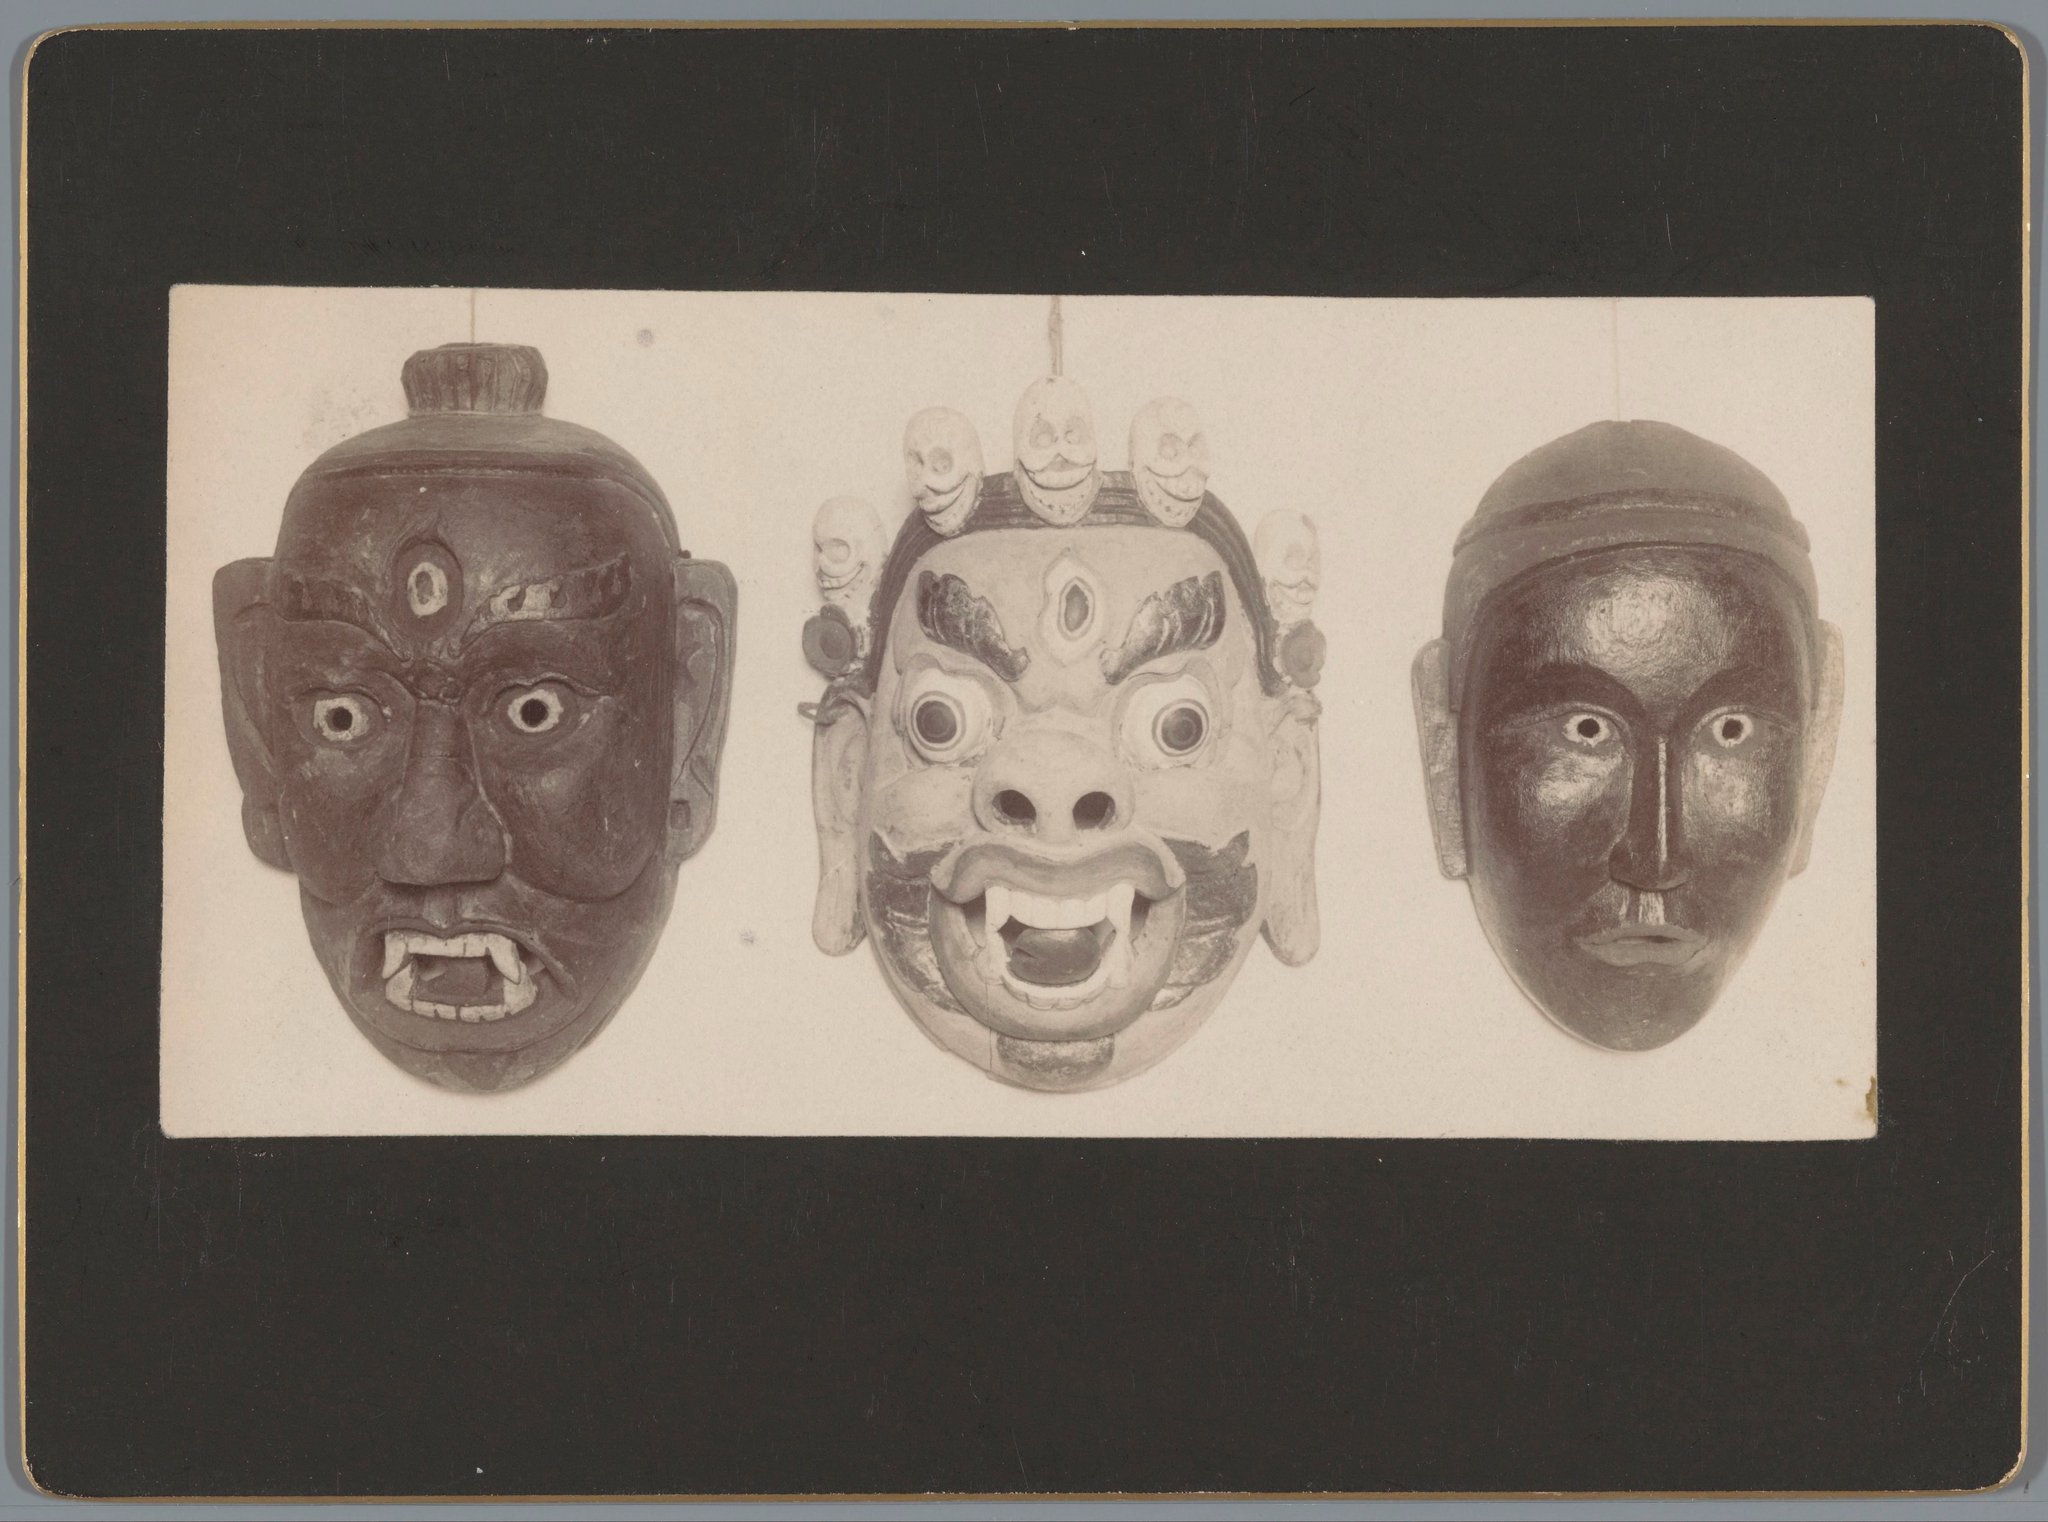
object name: photograph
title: Drie Tibetaanse maskers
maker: Anonymous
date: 1897-1910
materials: cardboard, paper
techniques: albumen print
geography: tibet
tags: mask